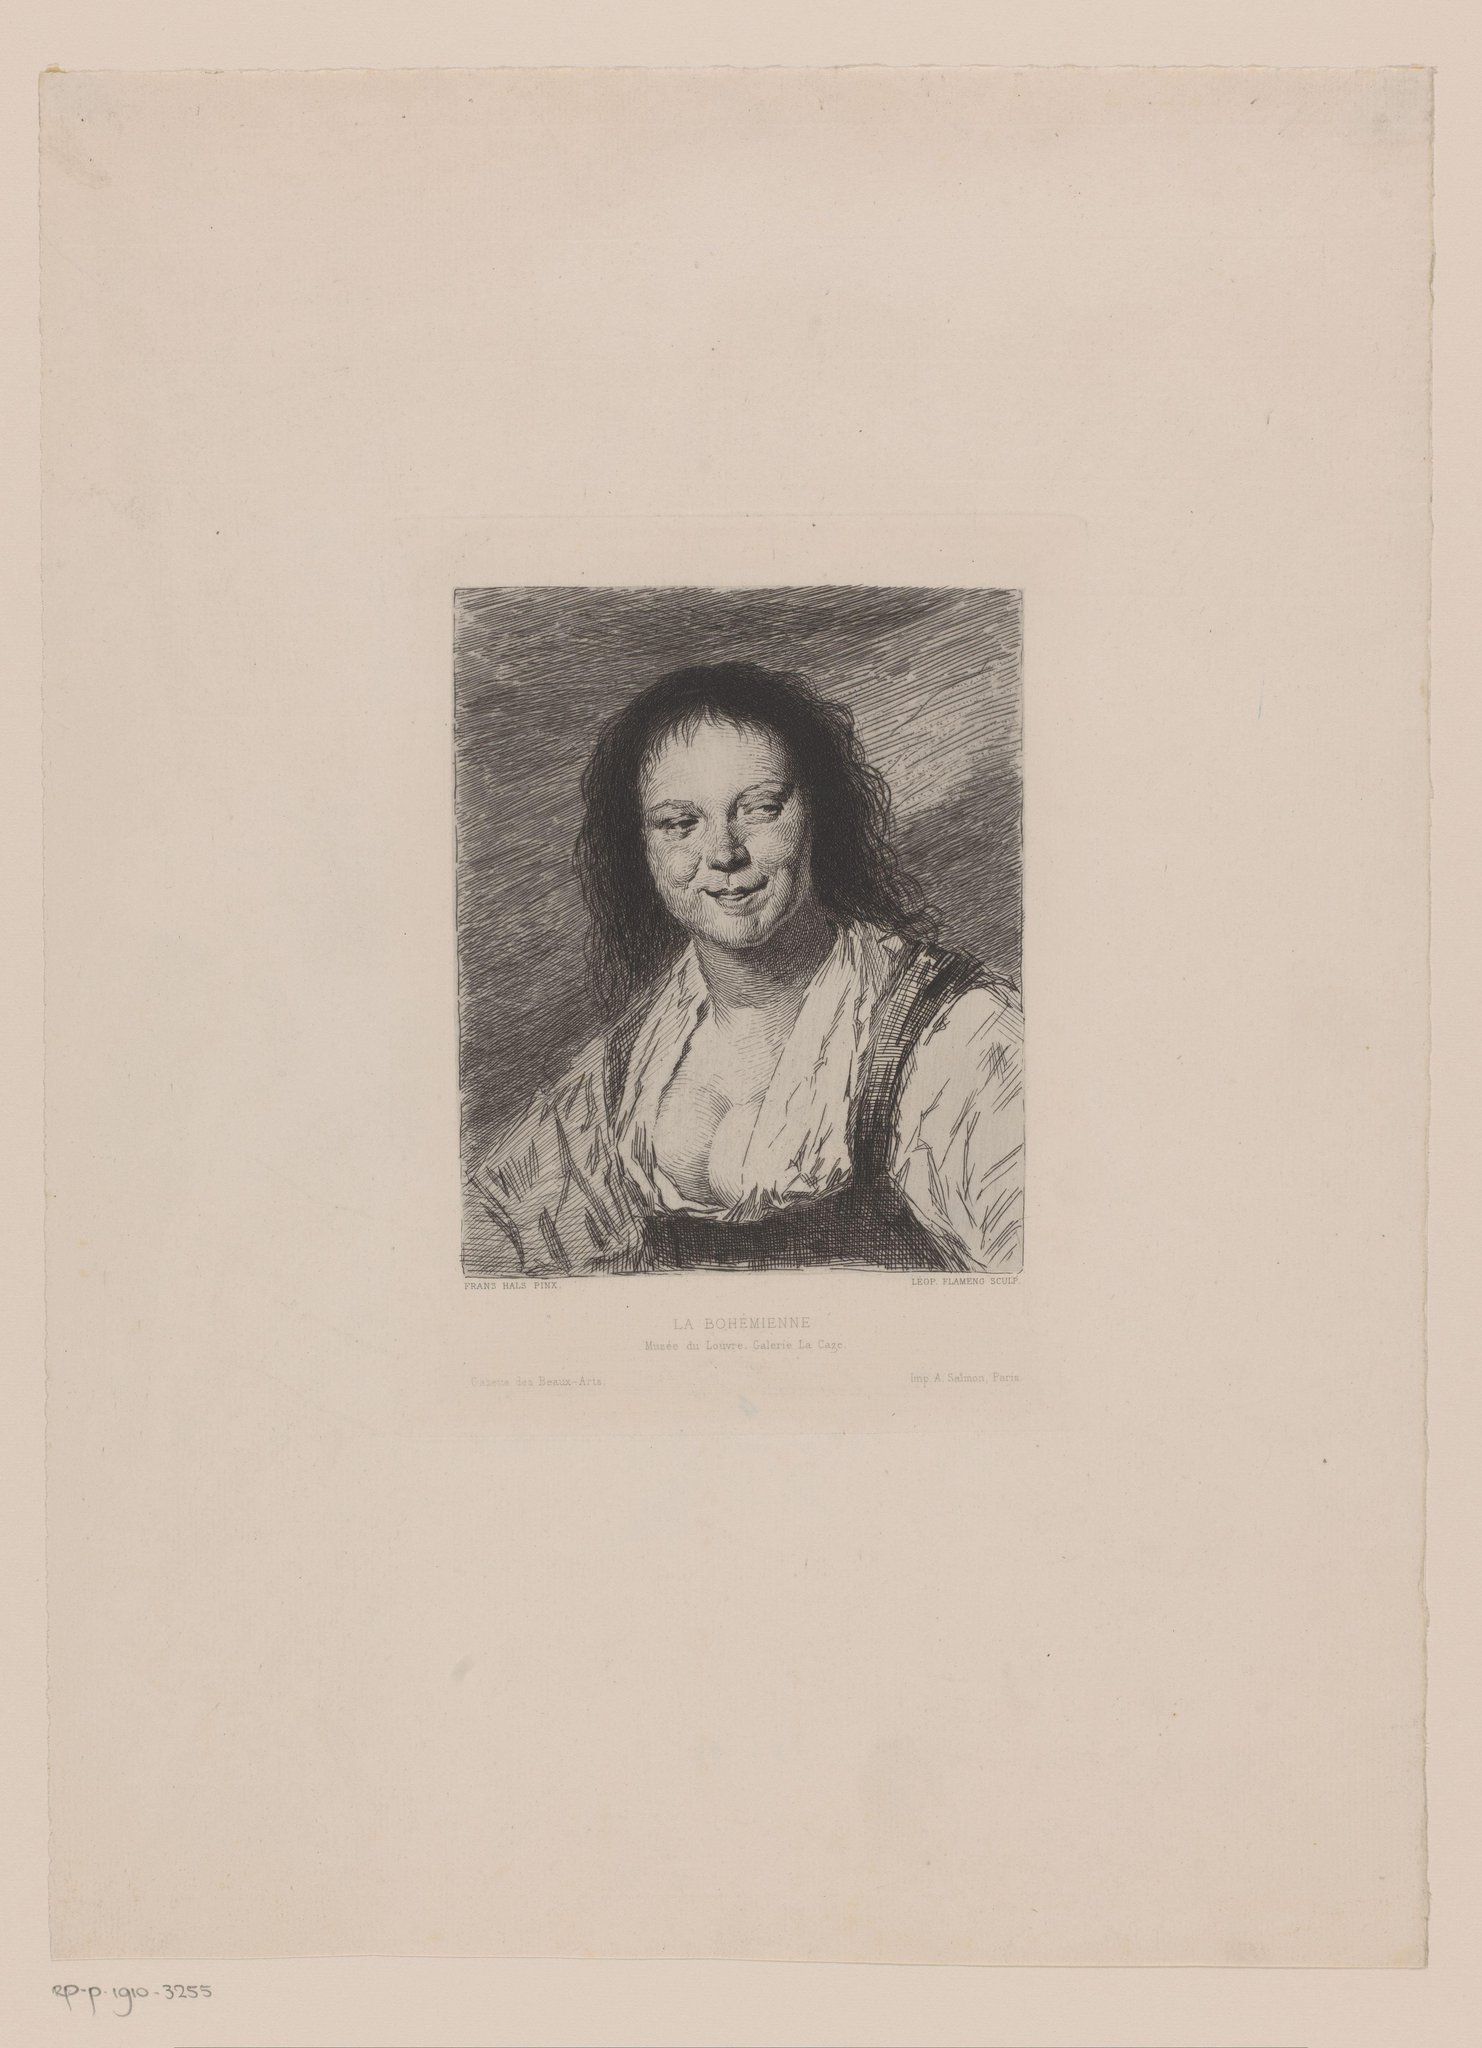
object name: print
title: Portret van een onbekend Roma meisje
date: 1870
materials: paper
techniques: drypoint, etching, intaglio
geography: paris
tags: wandering communities: romani or roma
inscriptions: collector's mark: Lugt 2228